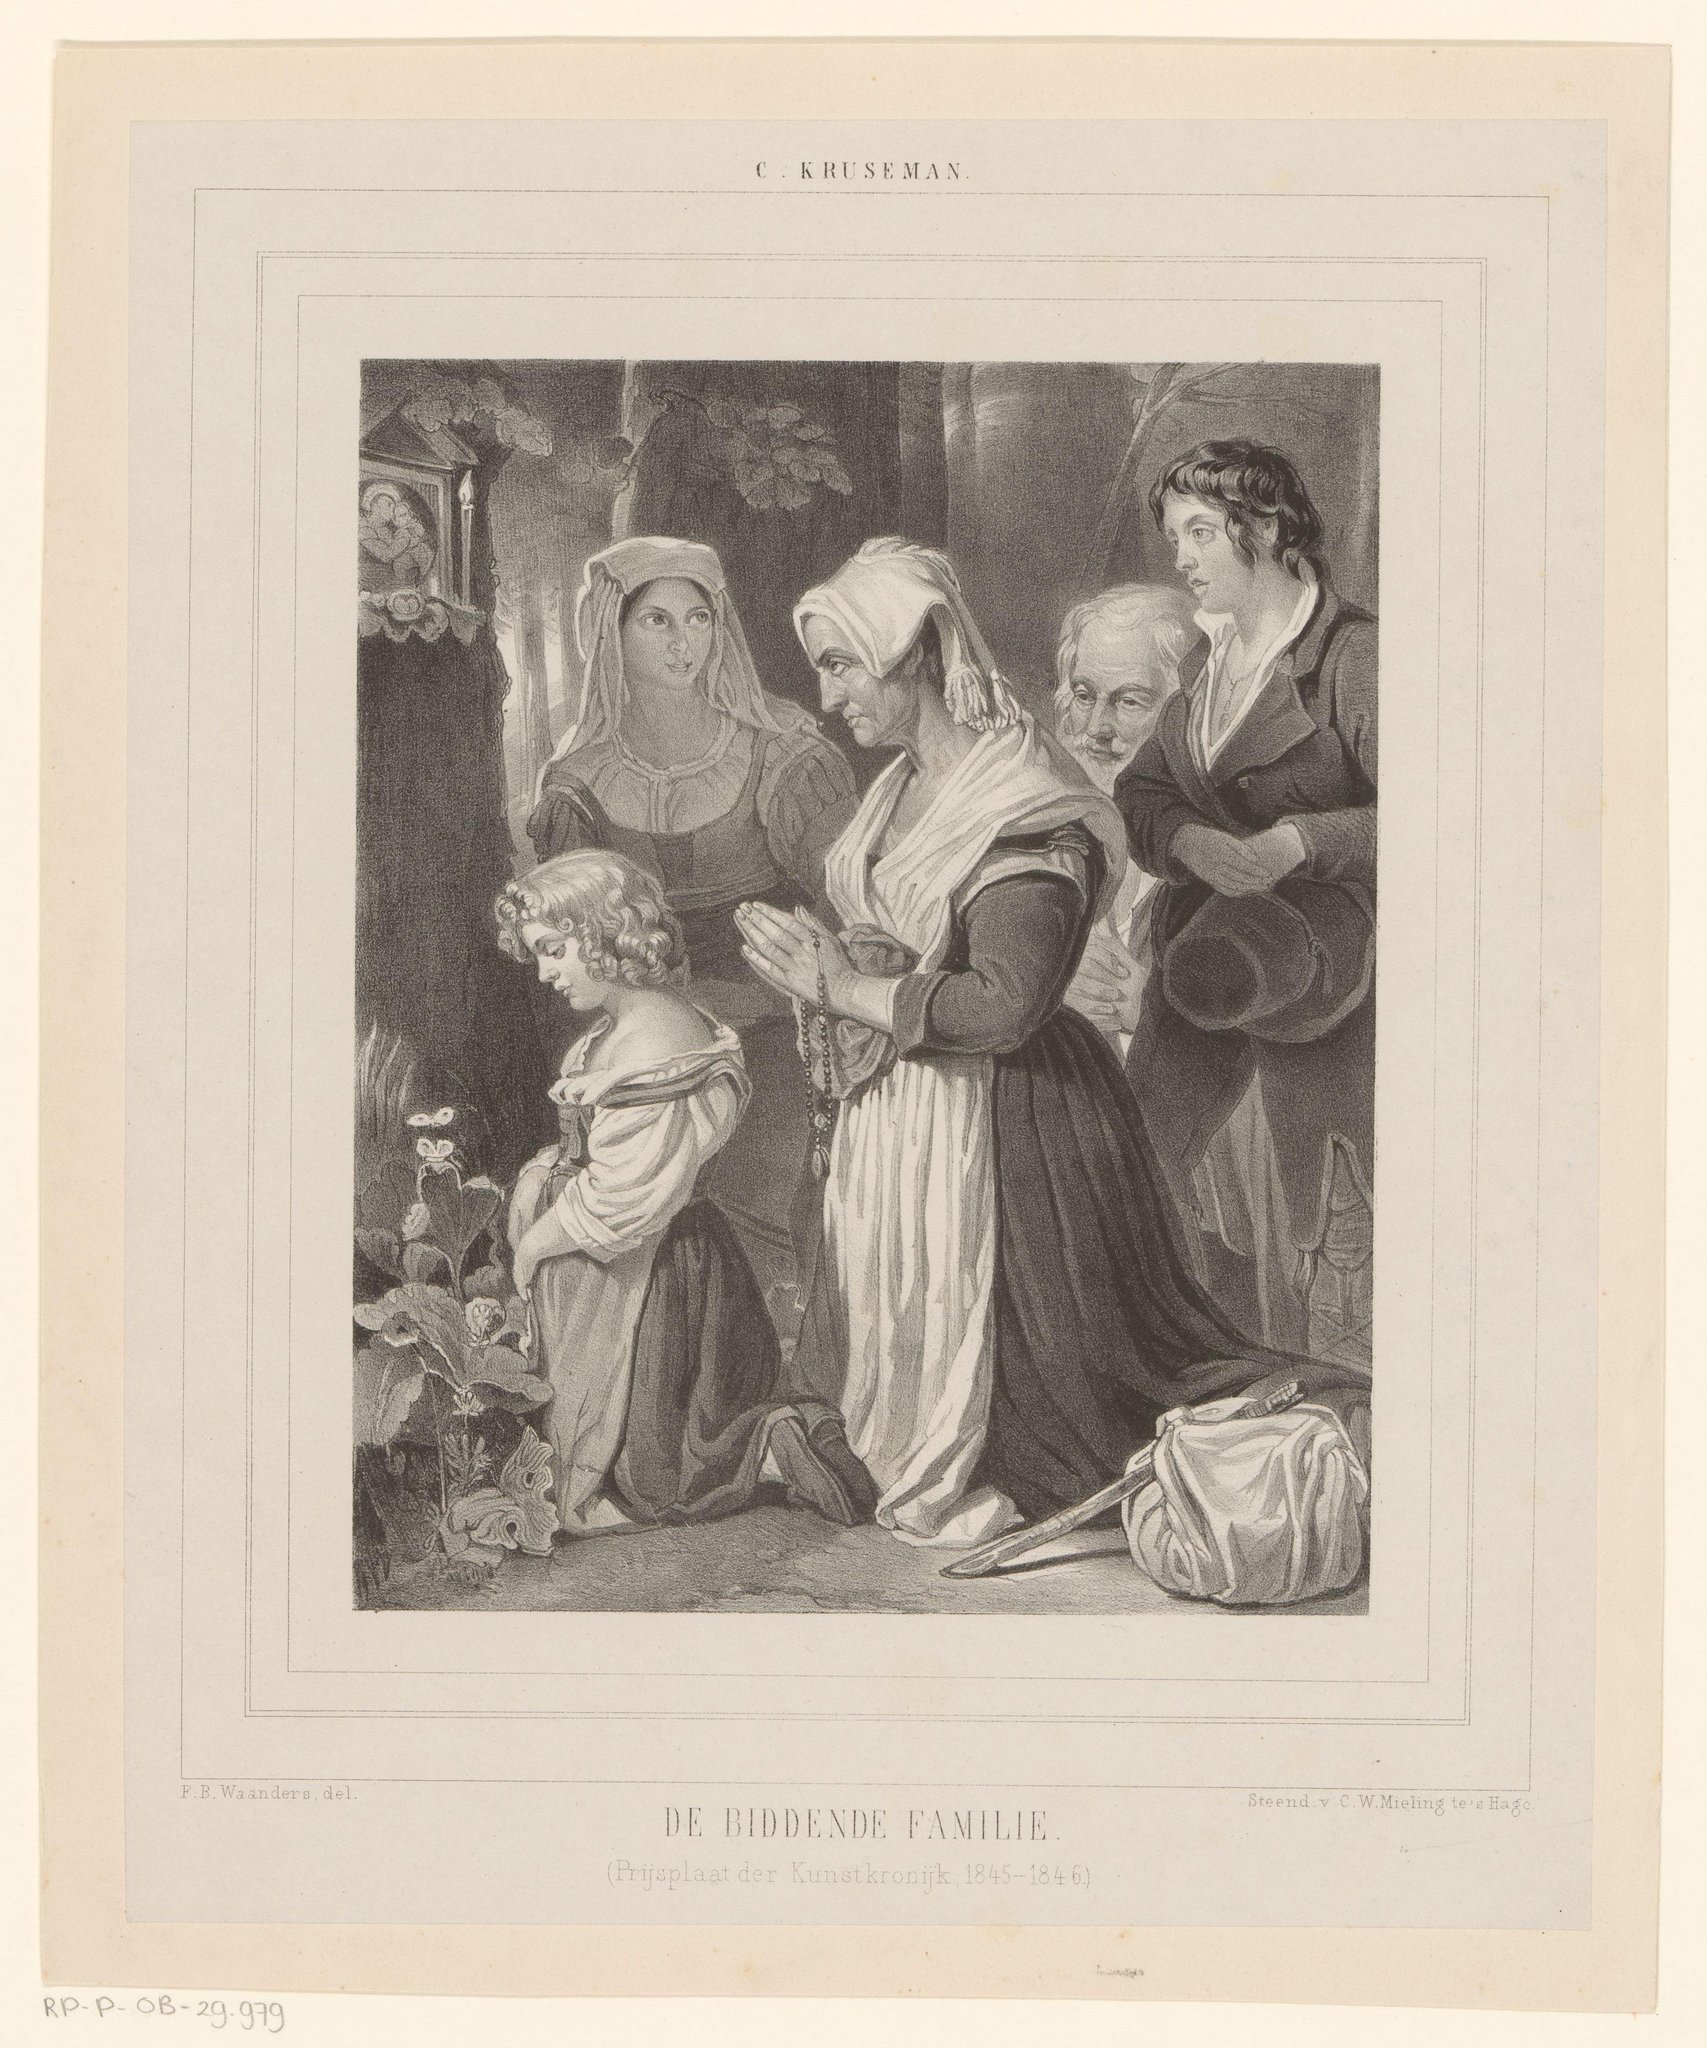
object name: print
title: Godsvrucht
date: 1845-1846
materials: paper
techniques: lithograph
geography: the hague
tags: (public) prayer, devotion, piety; 'divotione' (ripa), aids for prayer, e.g. rosary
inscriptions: collector's mark: Lugt 2228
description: Een groep biddende personen bij een Maria-altaartje langs een weg in een bos. In het midden een oude vrouw geknield met een rozenkrans in de gevouwen handen. Links een klein meisje en een jonge vrouw. Rechts een oude man en een staande jongen met zijn hoed in de handen. Links twee vlinders op een plant. Premieplaat bij Kunstkronijk 1845-46.